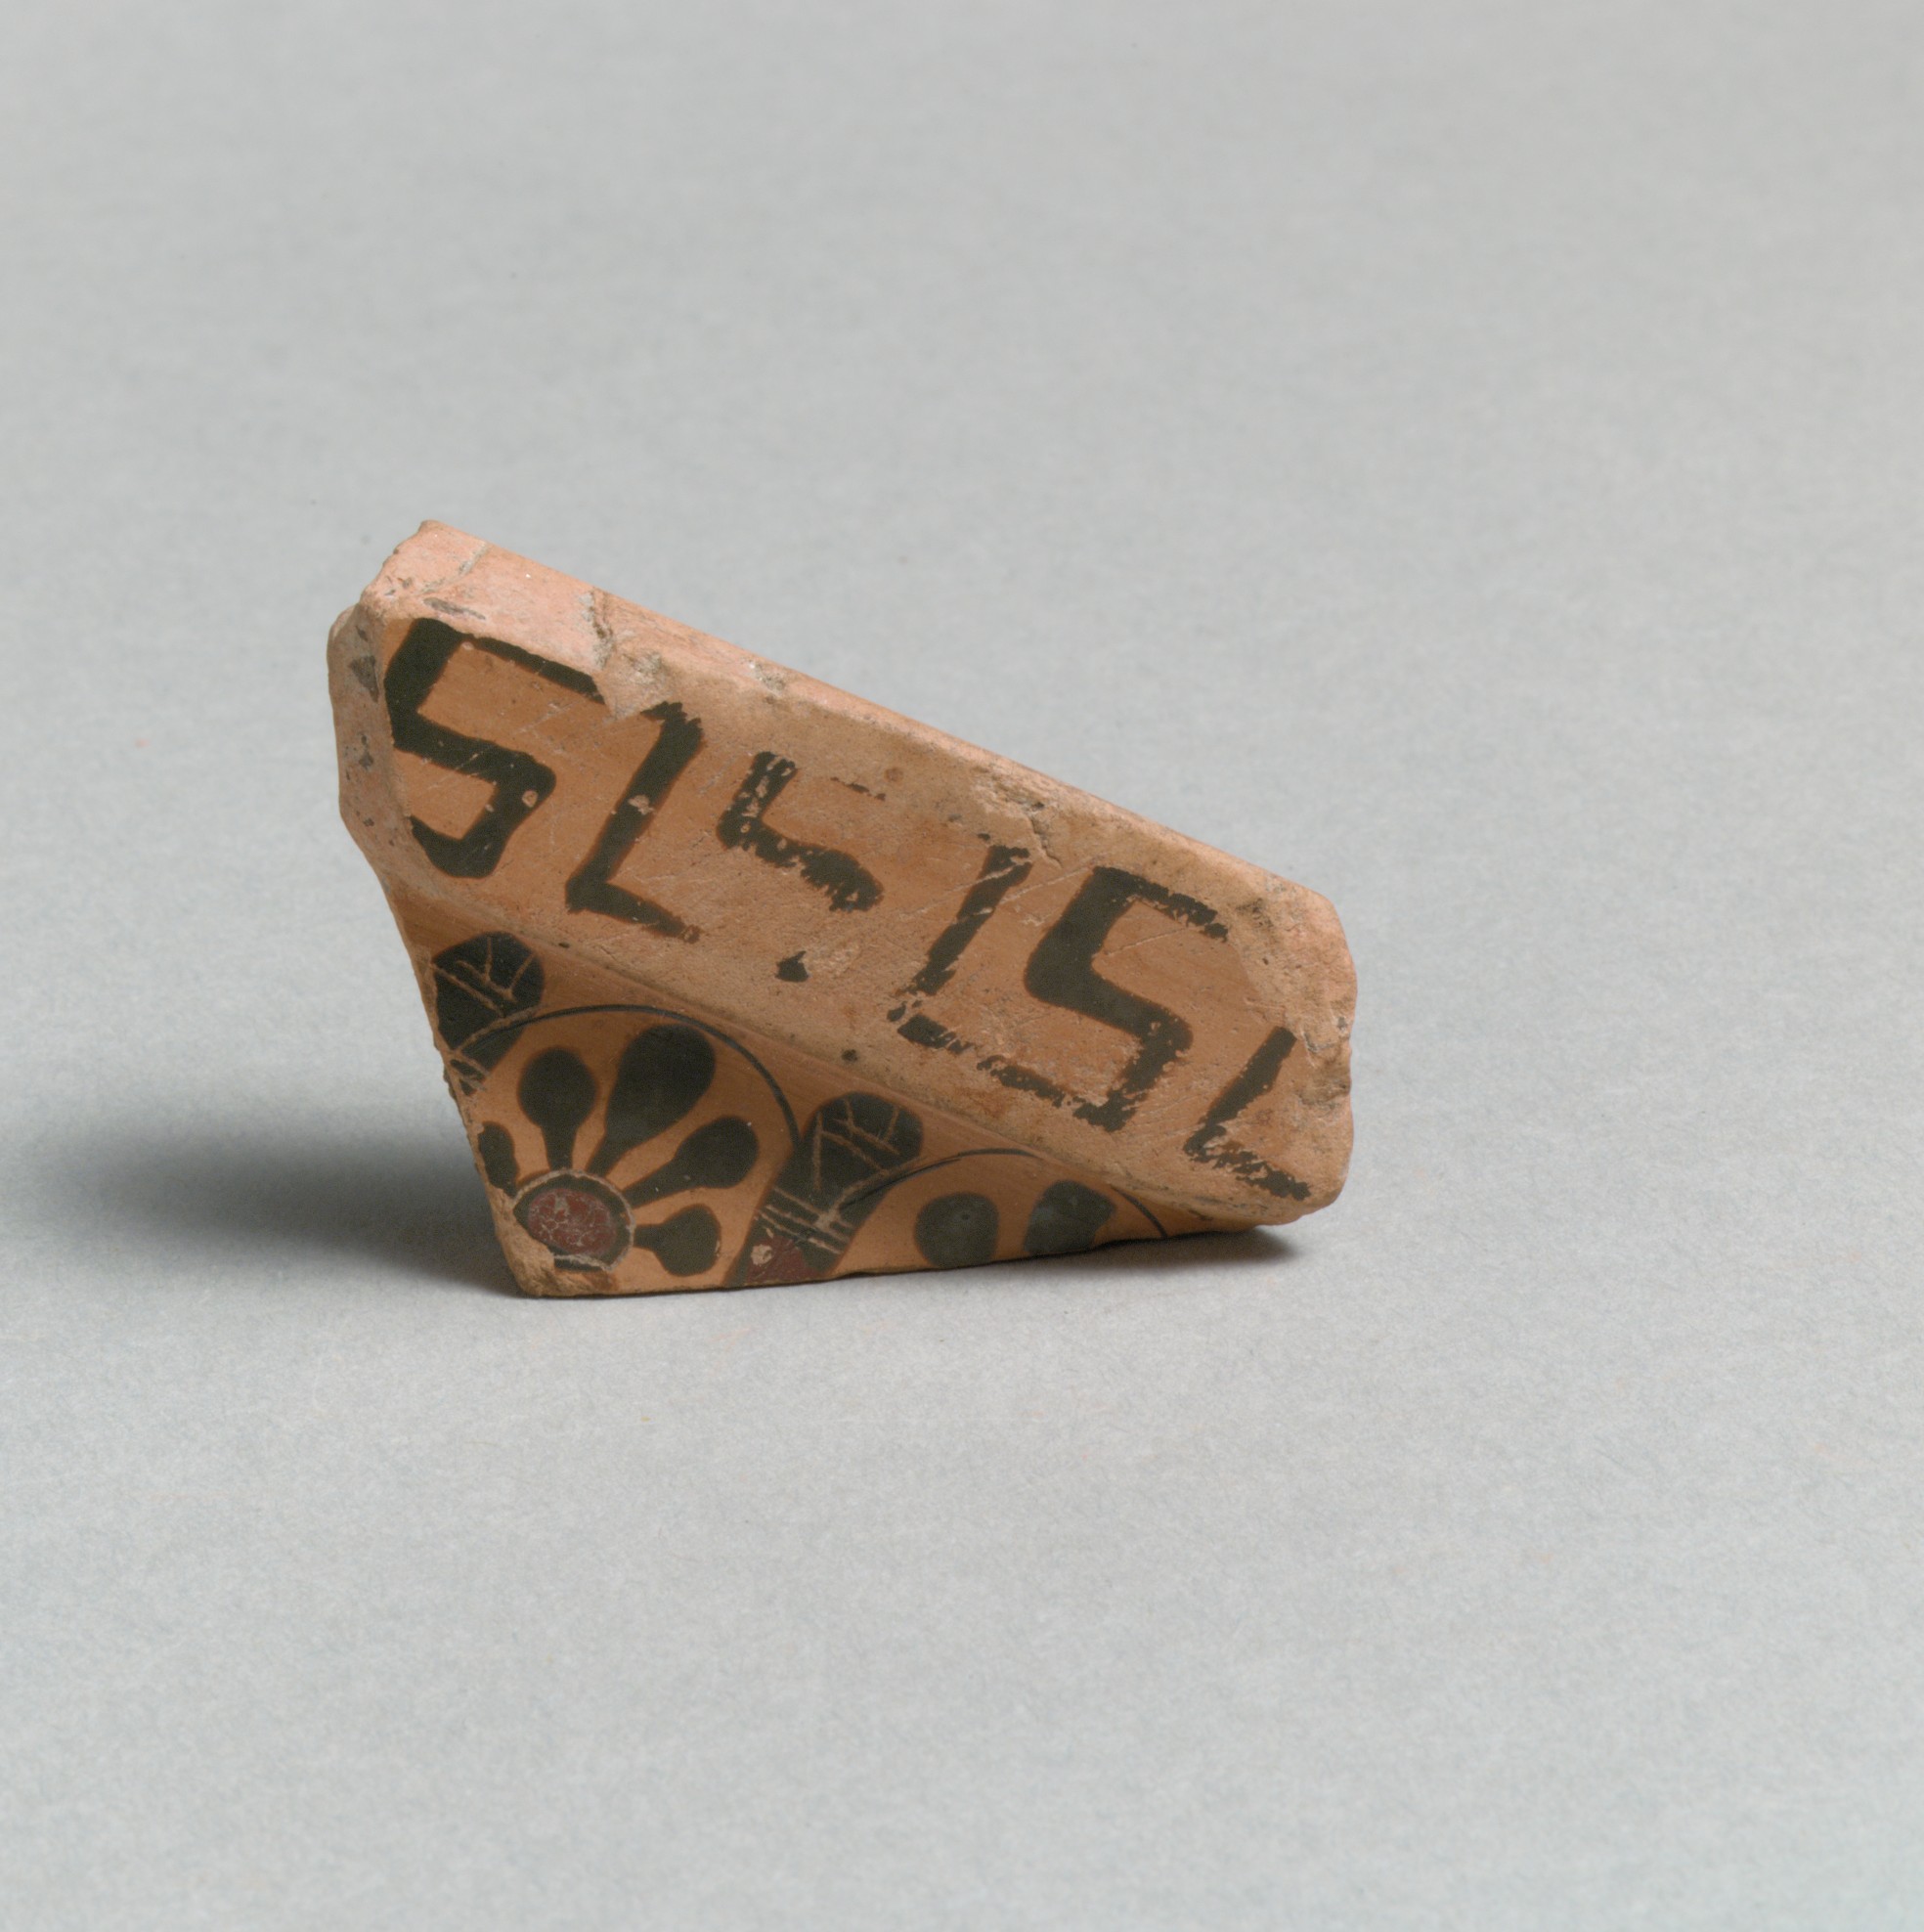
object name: volute krater fragment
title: Volute-krater fragment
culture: greek, attic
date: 530 BCE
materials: terracotta